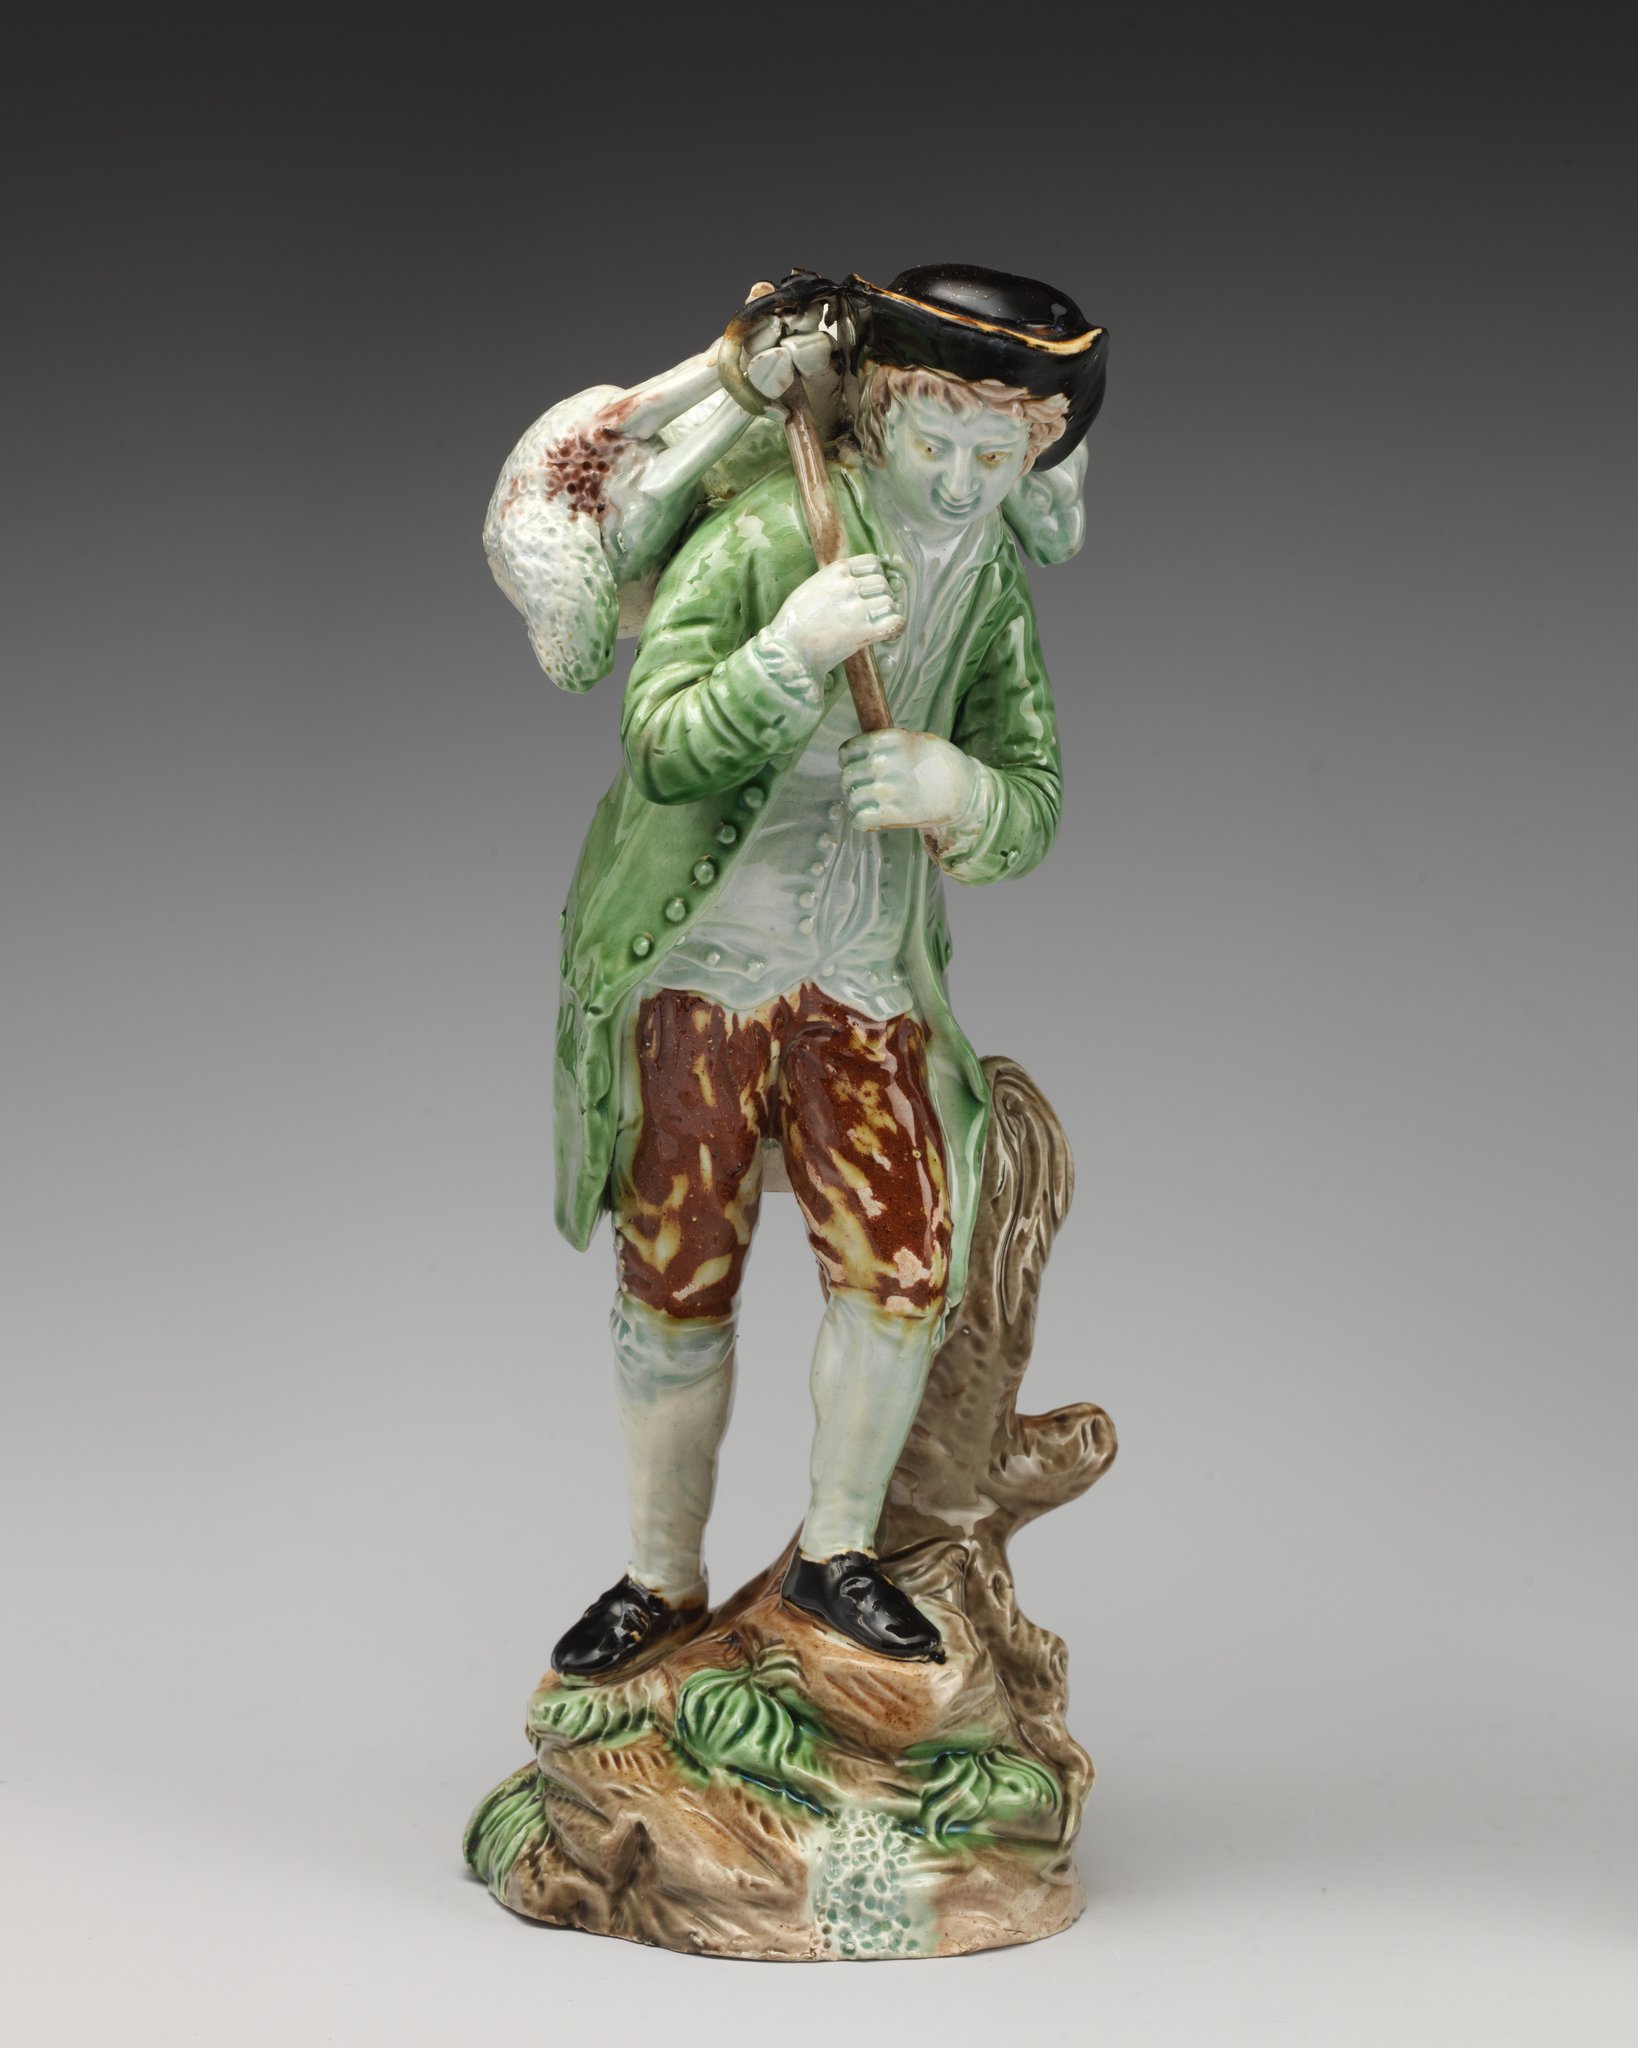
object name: figure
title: Farmer carrying trussed sheep over his shoulder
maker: ralph wood the younger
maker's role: maker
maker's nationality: british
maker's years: 1748-1795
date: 1780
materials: earthenware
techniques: glazing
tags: men,sheep,farmers